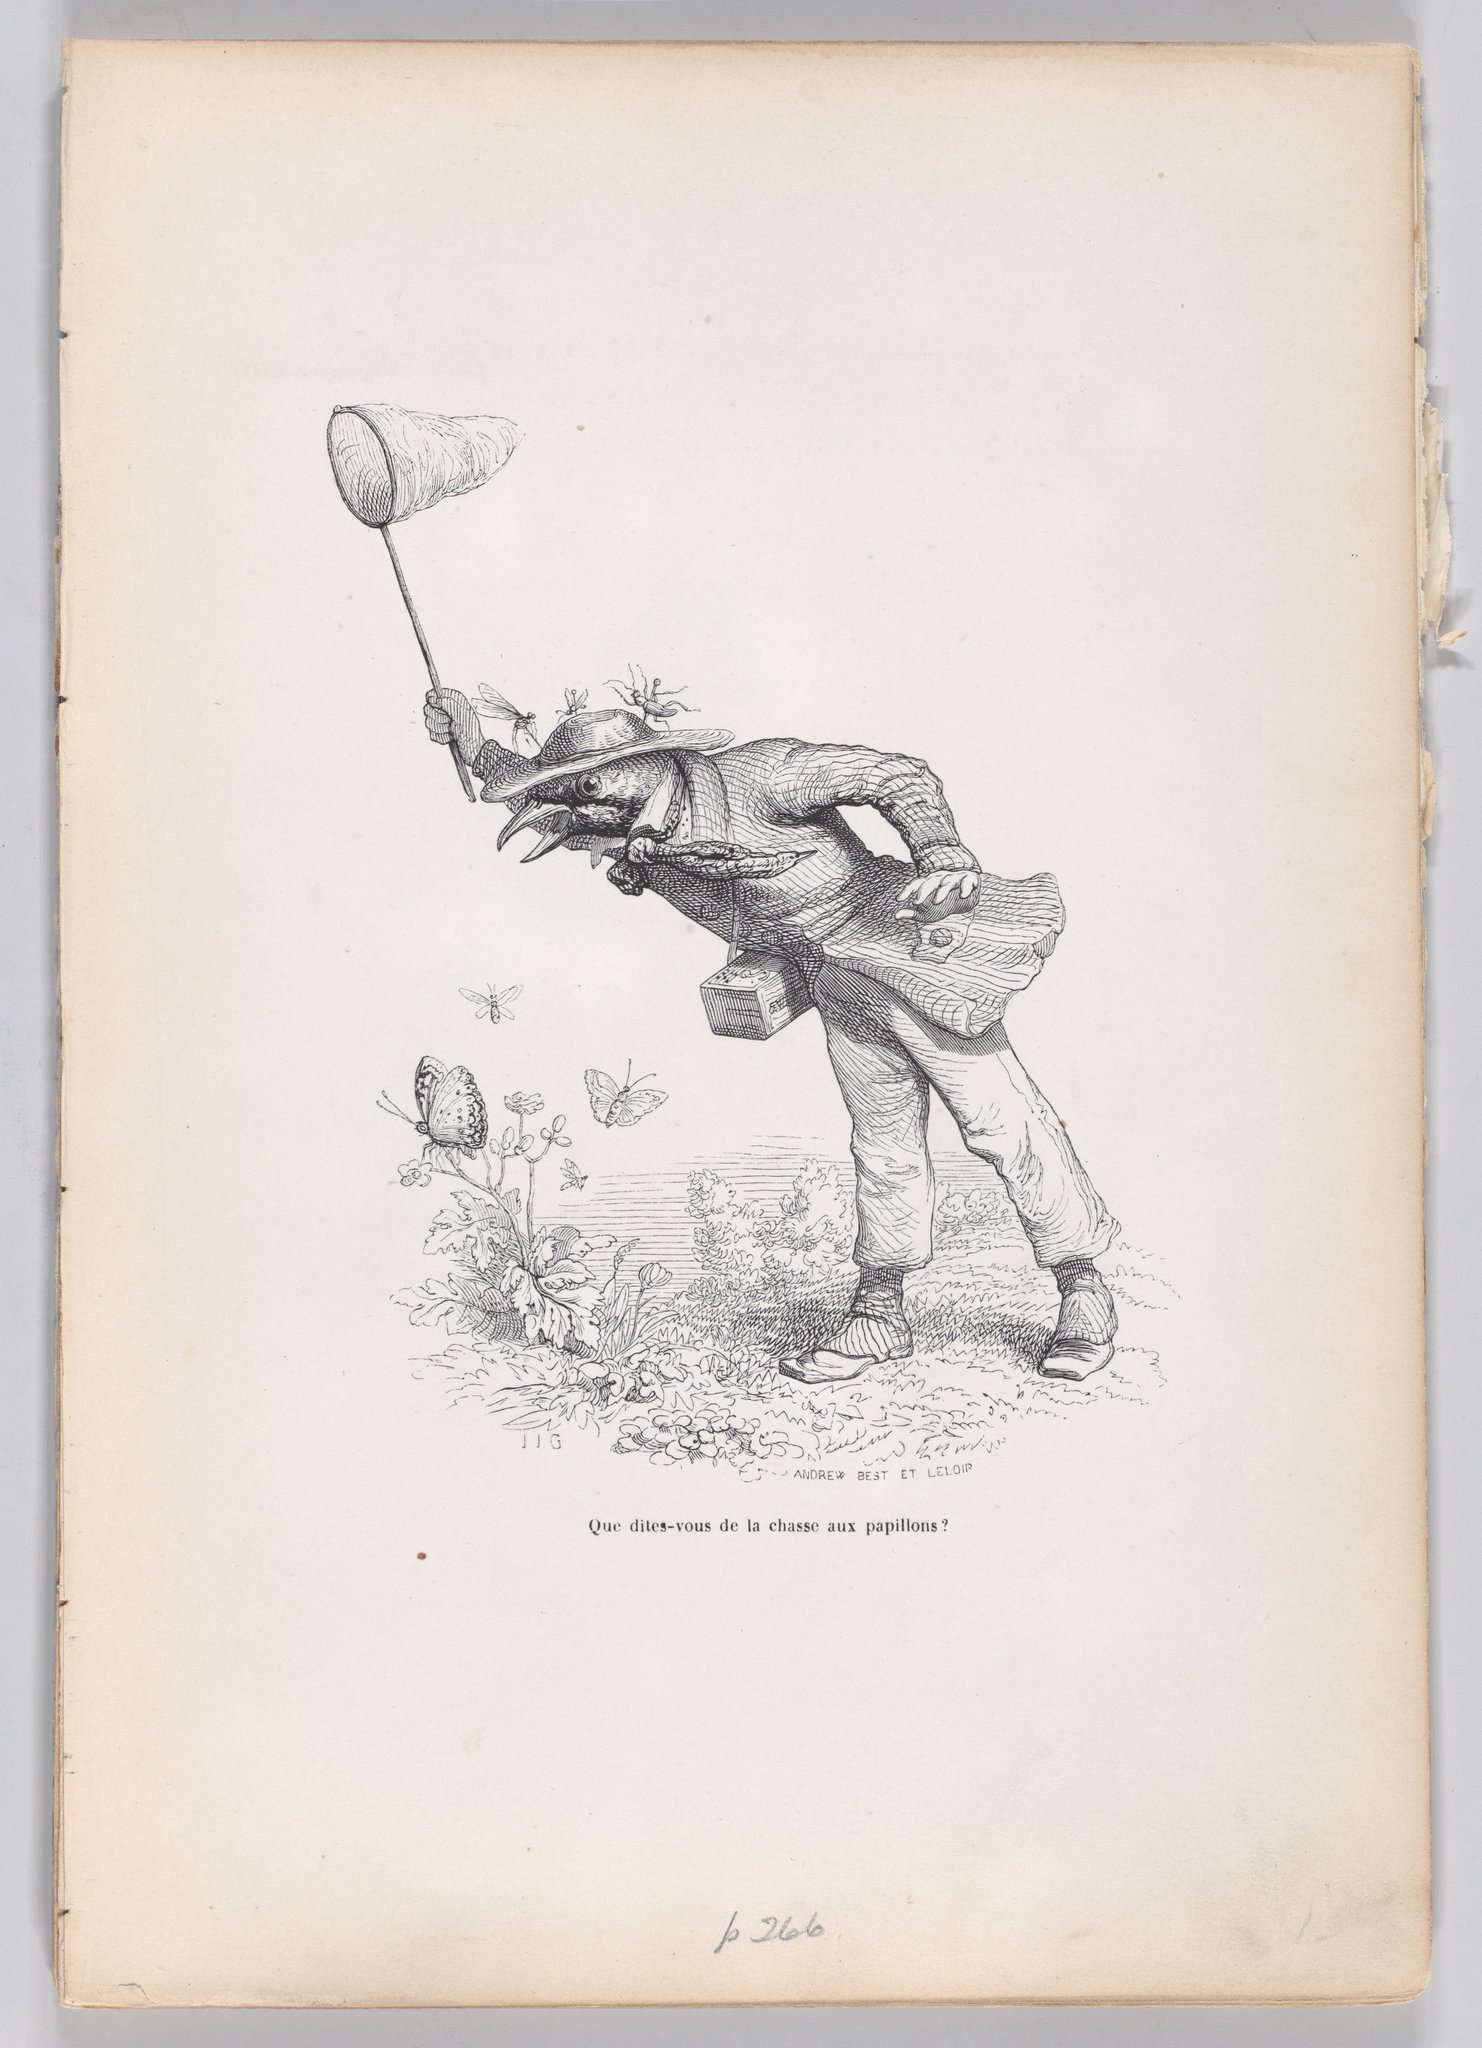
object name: print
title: What do you say about the butterfly hunt?, from "Scenes from the Private and Public Life of Animals"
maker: j. j. grandville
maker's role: illustrator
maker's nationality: french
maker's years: 1803-1847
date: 1837-1847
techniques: engraving